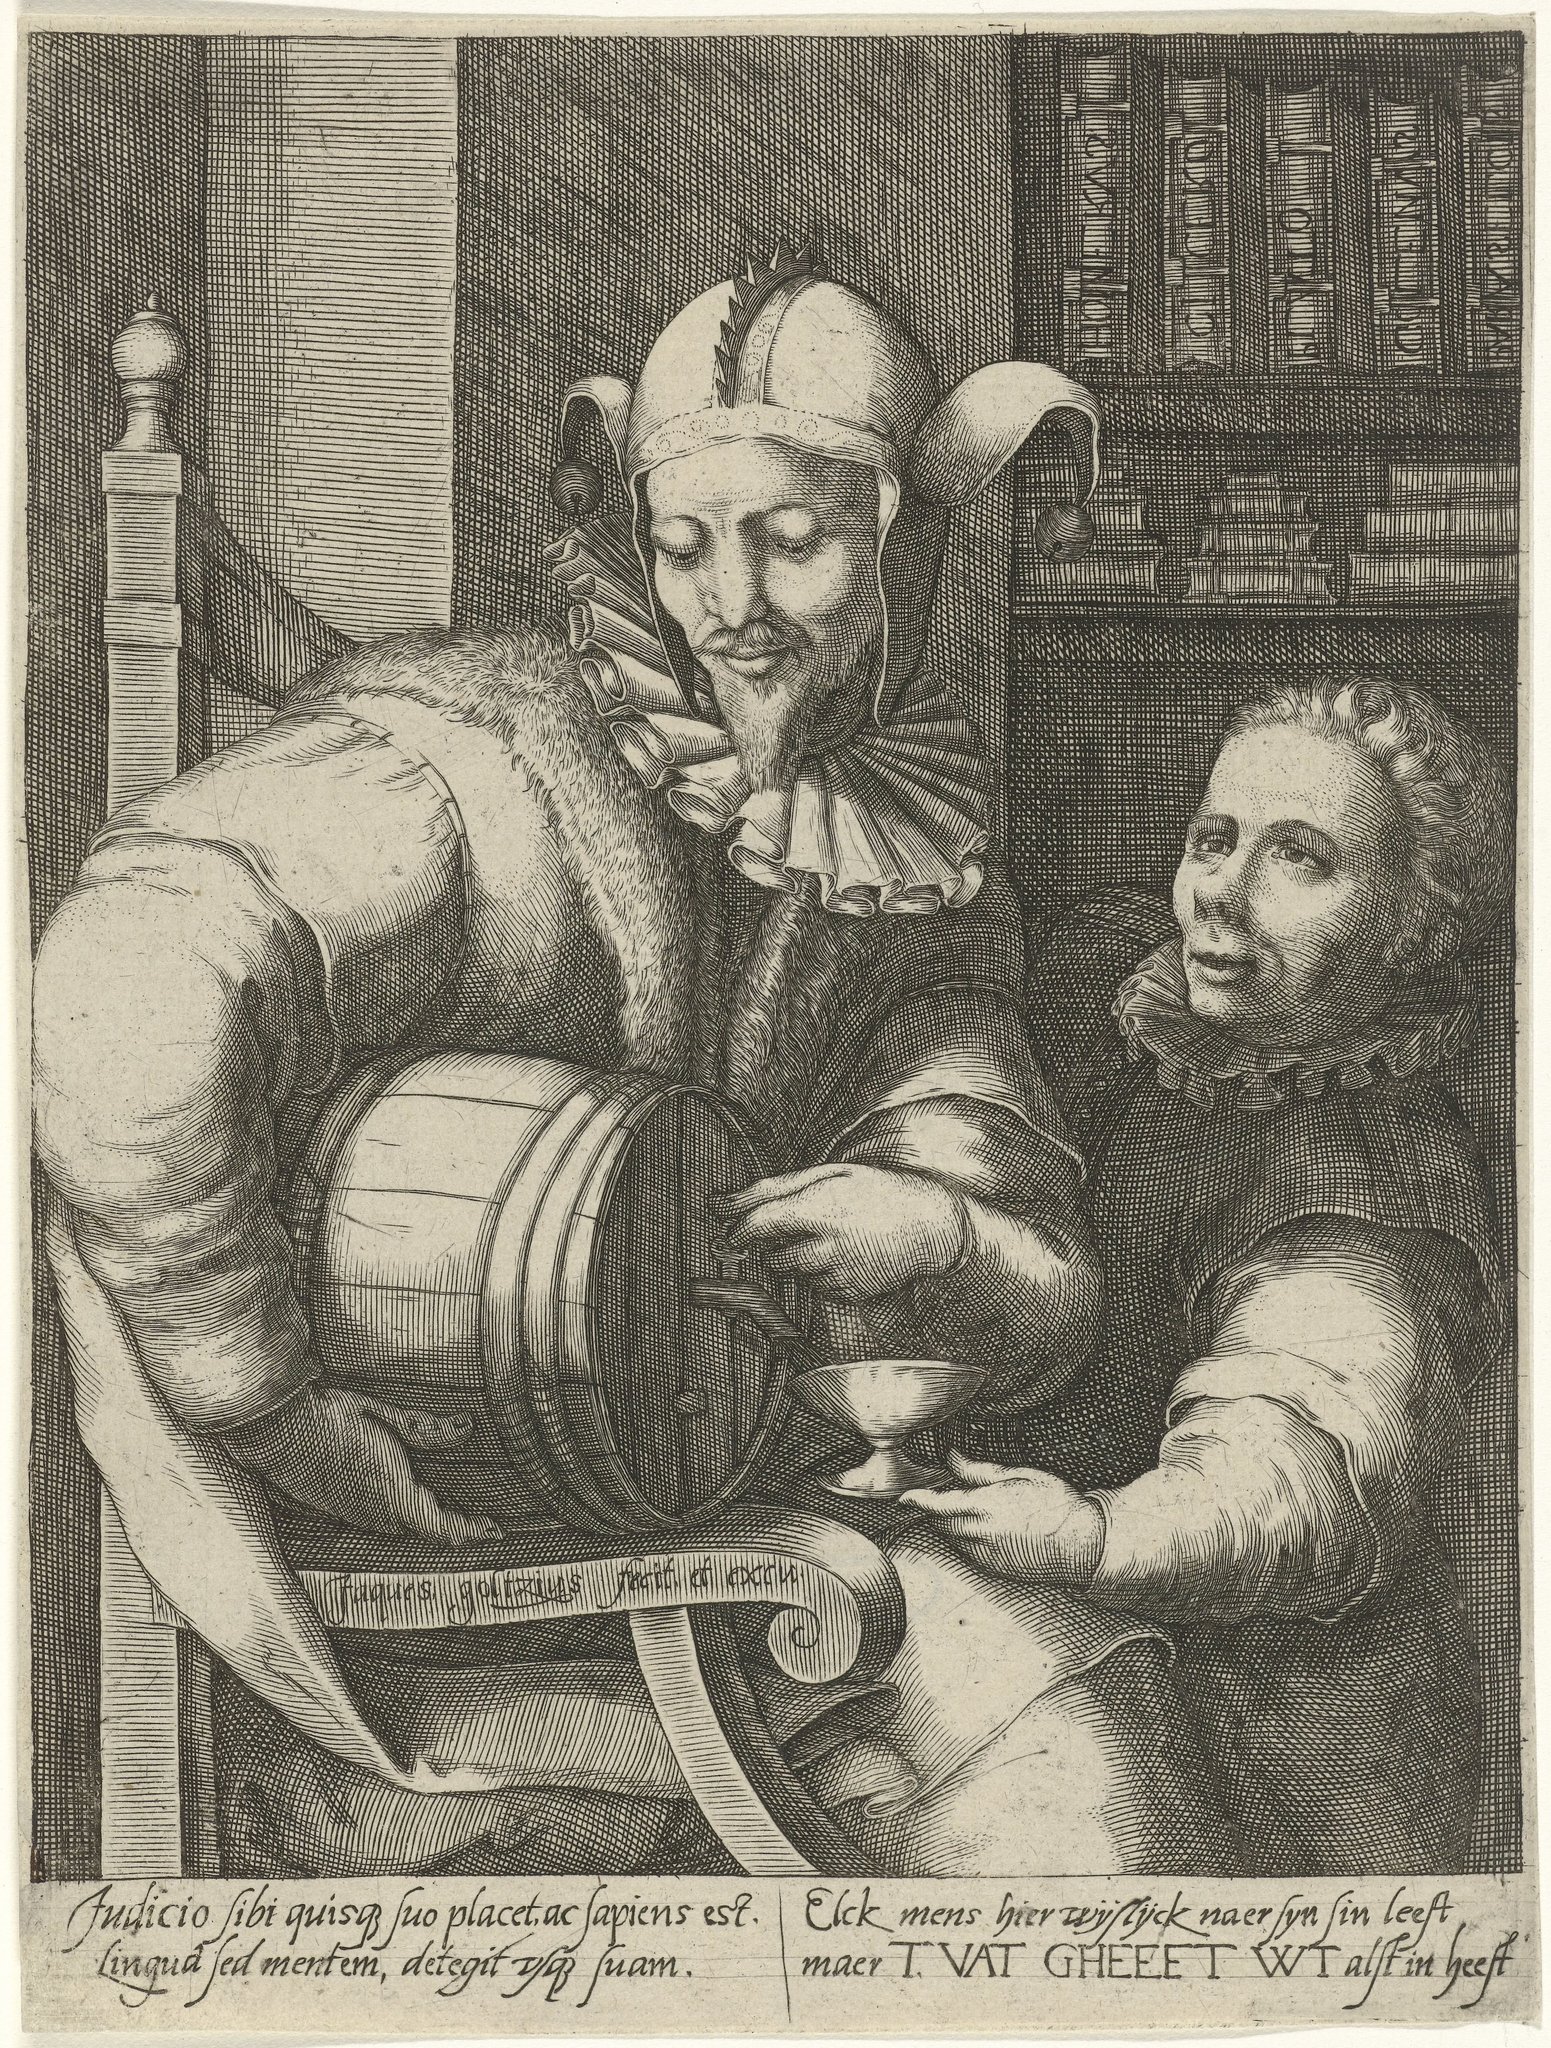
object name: print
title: Nar met vat wijn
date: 1584-1630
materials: paper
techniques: engraving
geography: haarlem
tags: court jester, court fool, book, wine ~ alcoholic drinks, proverbs, sayings, etc.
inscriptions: collector's mark: Lugt 2228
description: Een nar, zittend op een stoel. Onder zijn arm een vaatje met een kraantje. Een man houdt een schaal onder het kraantje en vult het met wijn. Op de achtergrond een boekenkast vol met boeken. De prent heeft een Latijns en Nederlands onderschrift met een wijze spreuk.